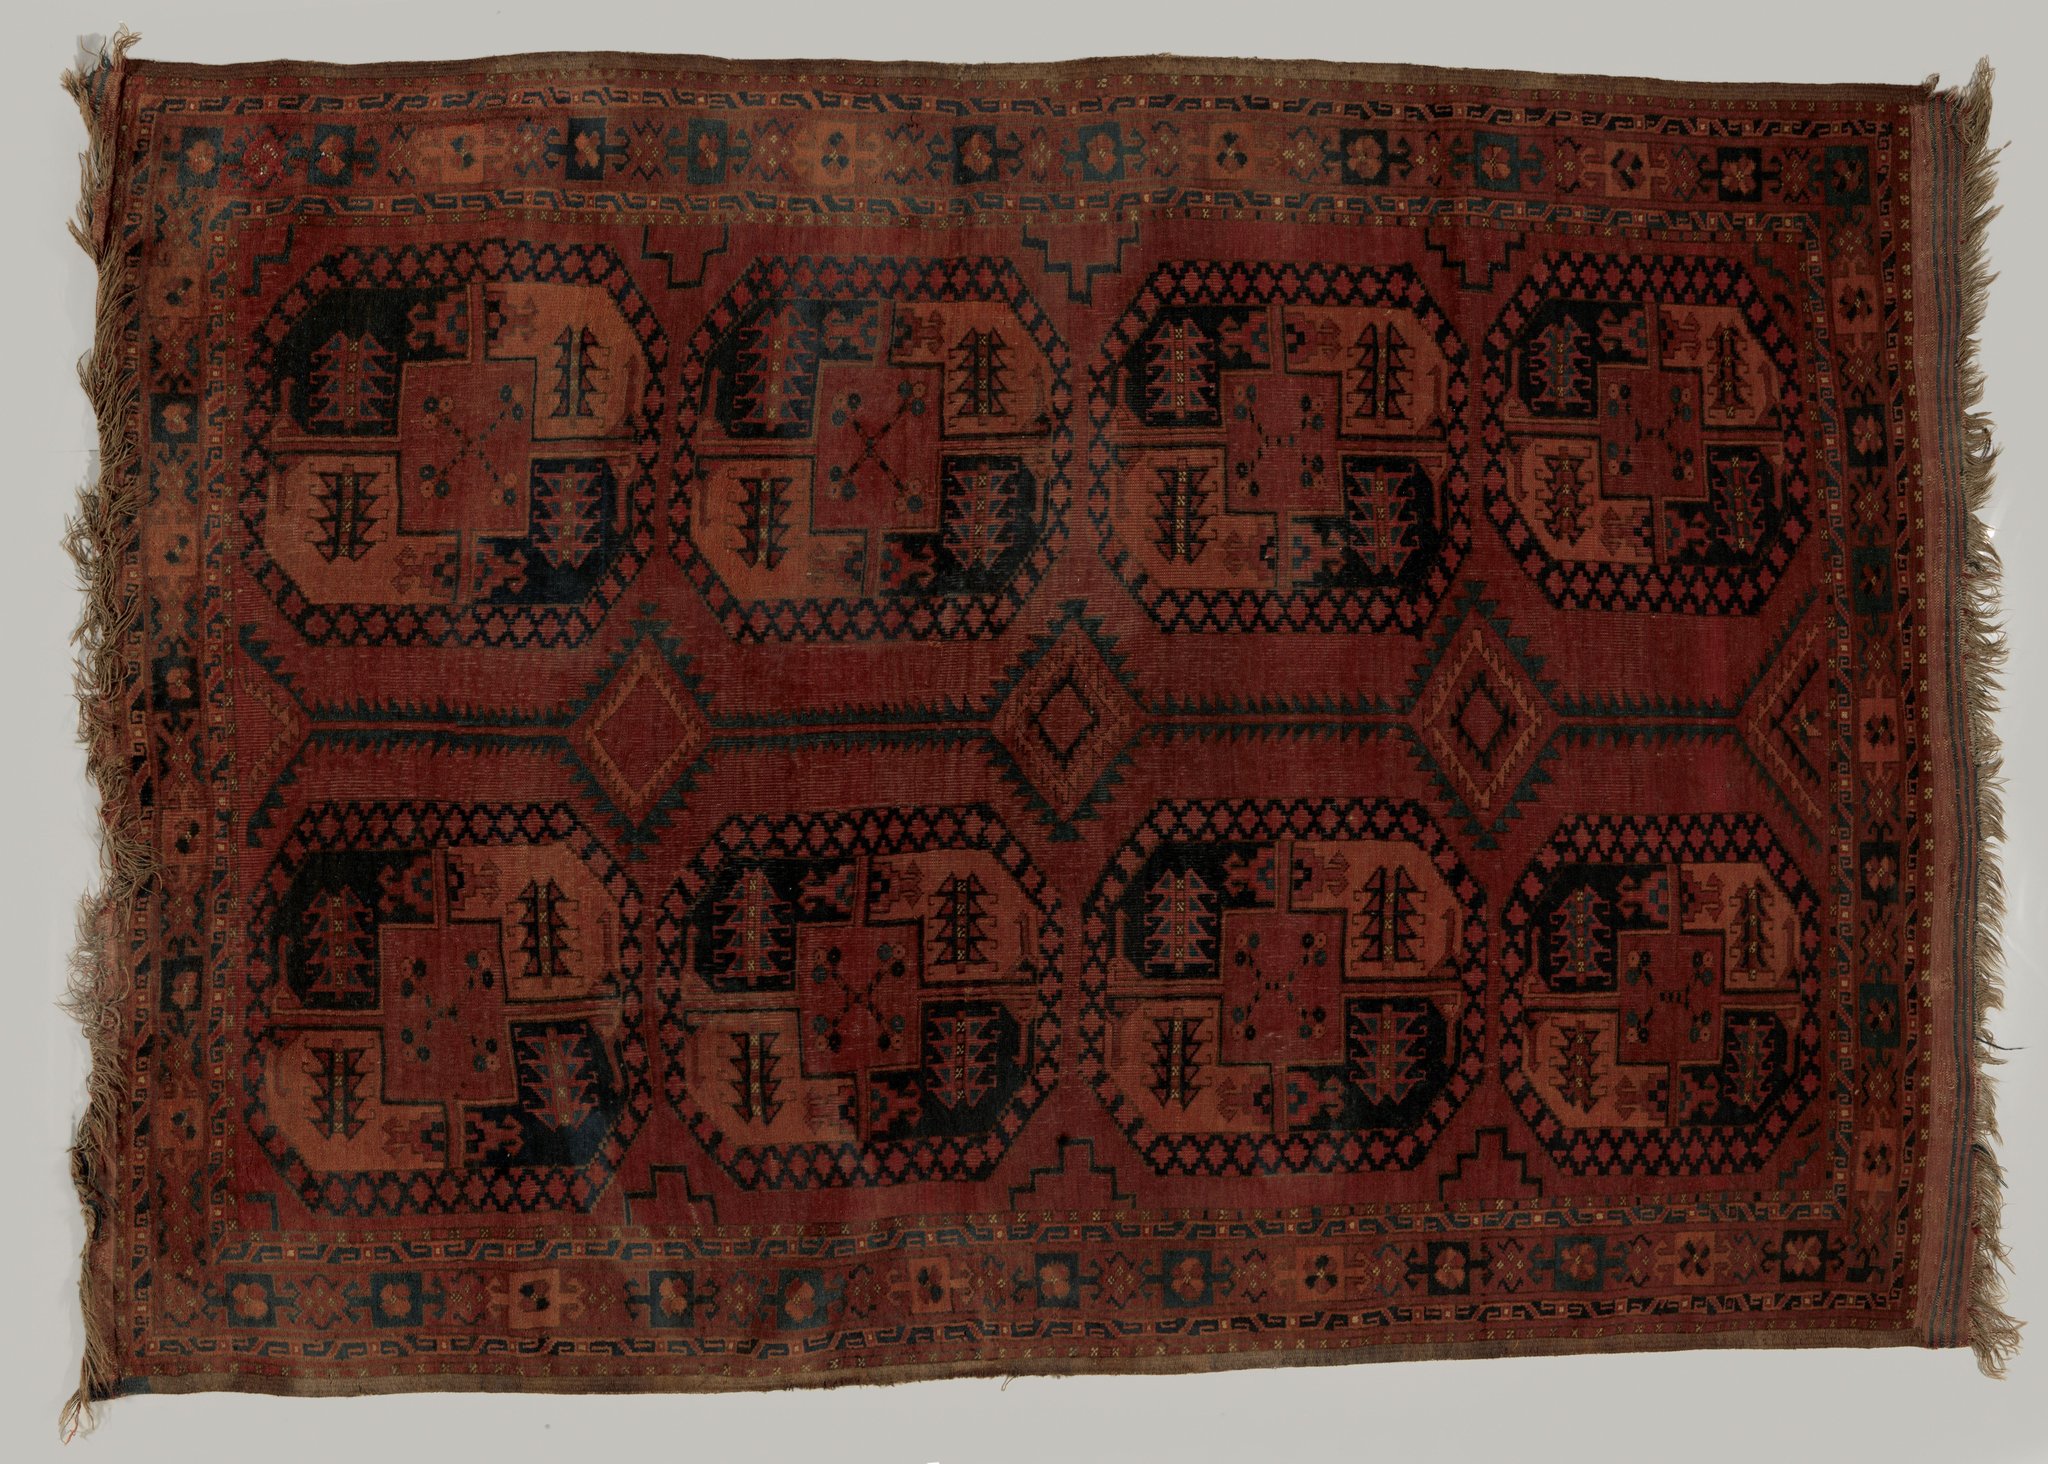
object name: tapijt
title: Oosters tapijt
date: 1800-1975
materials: wool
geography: central asia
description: Oosters tapijt, achthoekenkleed, met in het middenveld z.g. Temirdschin-guls tegen een rode achtergrond. De guls worden afgewisseld door eenvoudige geometrische ornamenten, die langs de verticale as onderling zijn verbonden. Rand met gotschanak motieven.